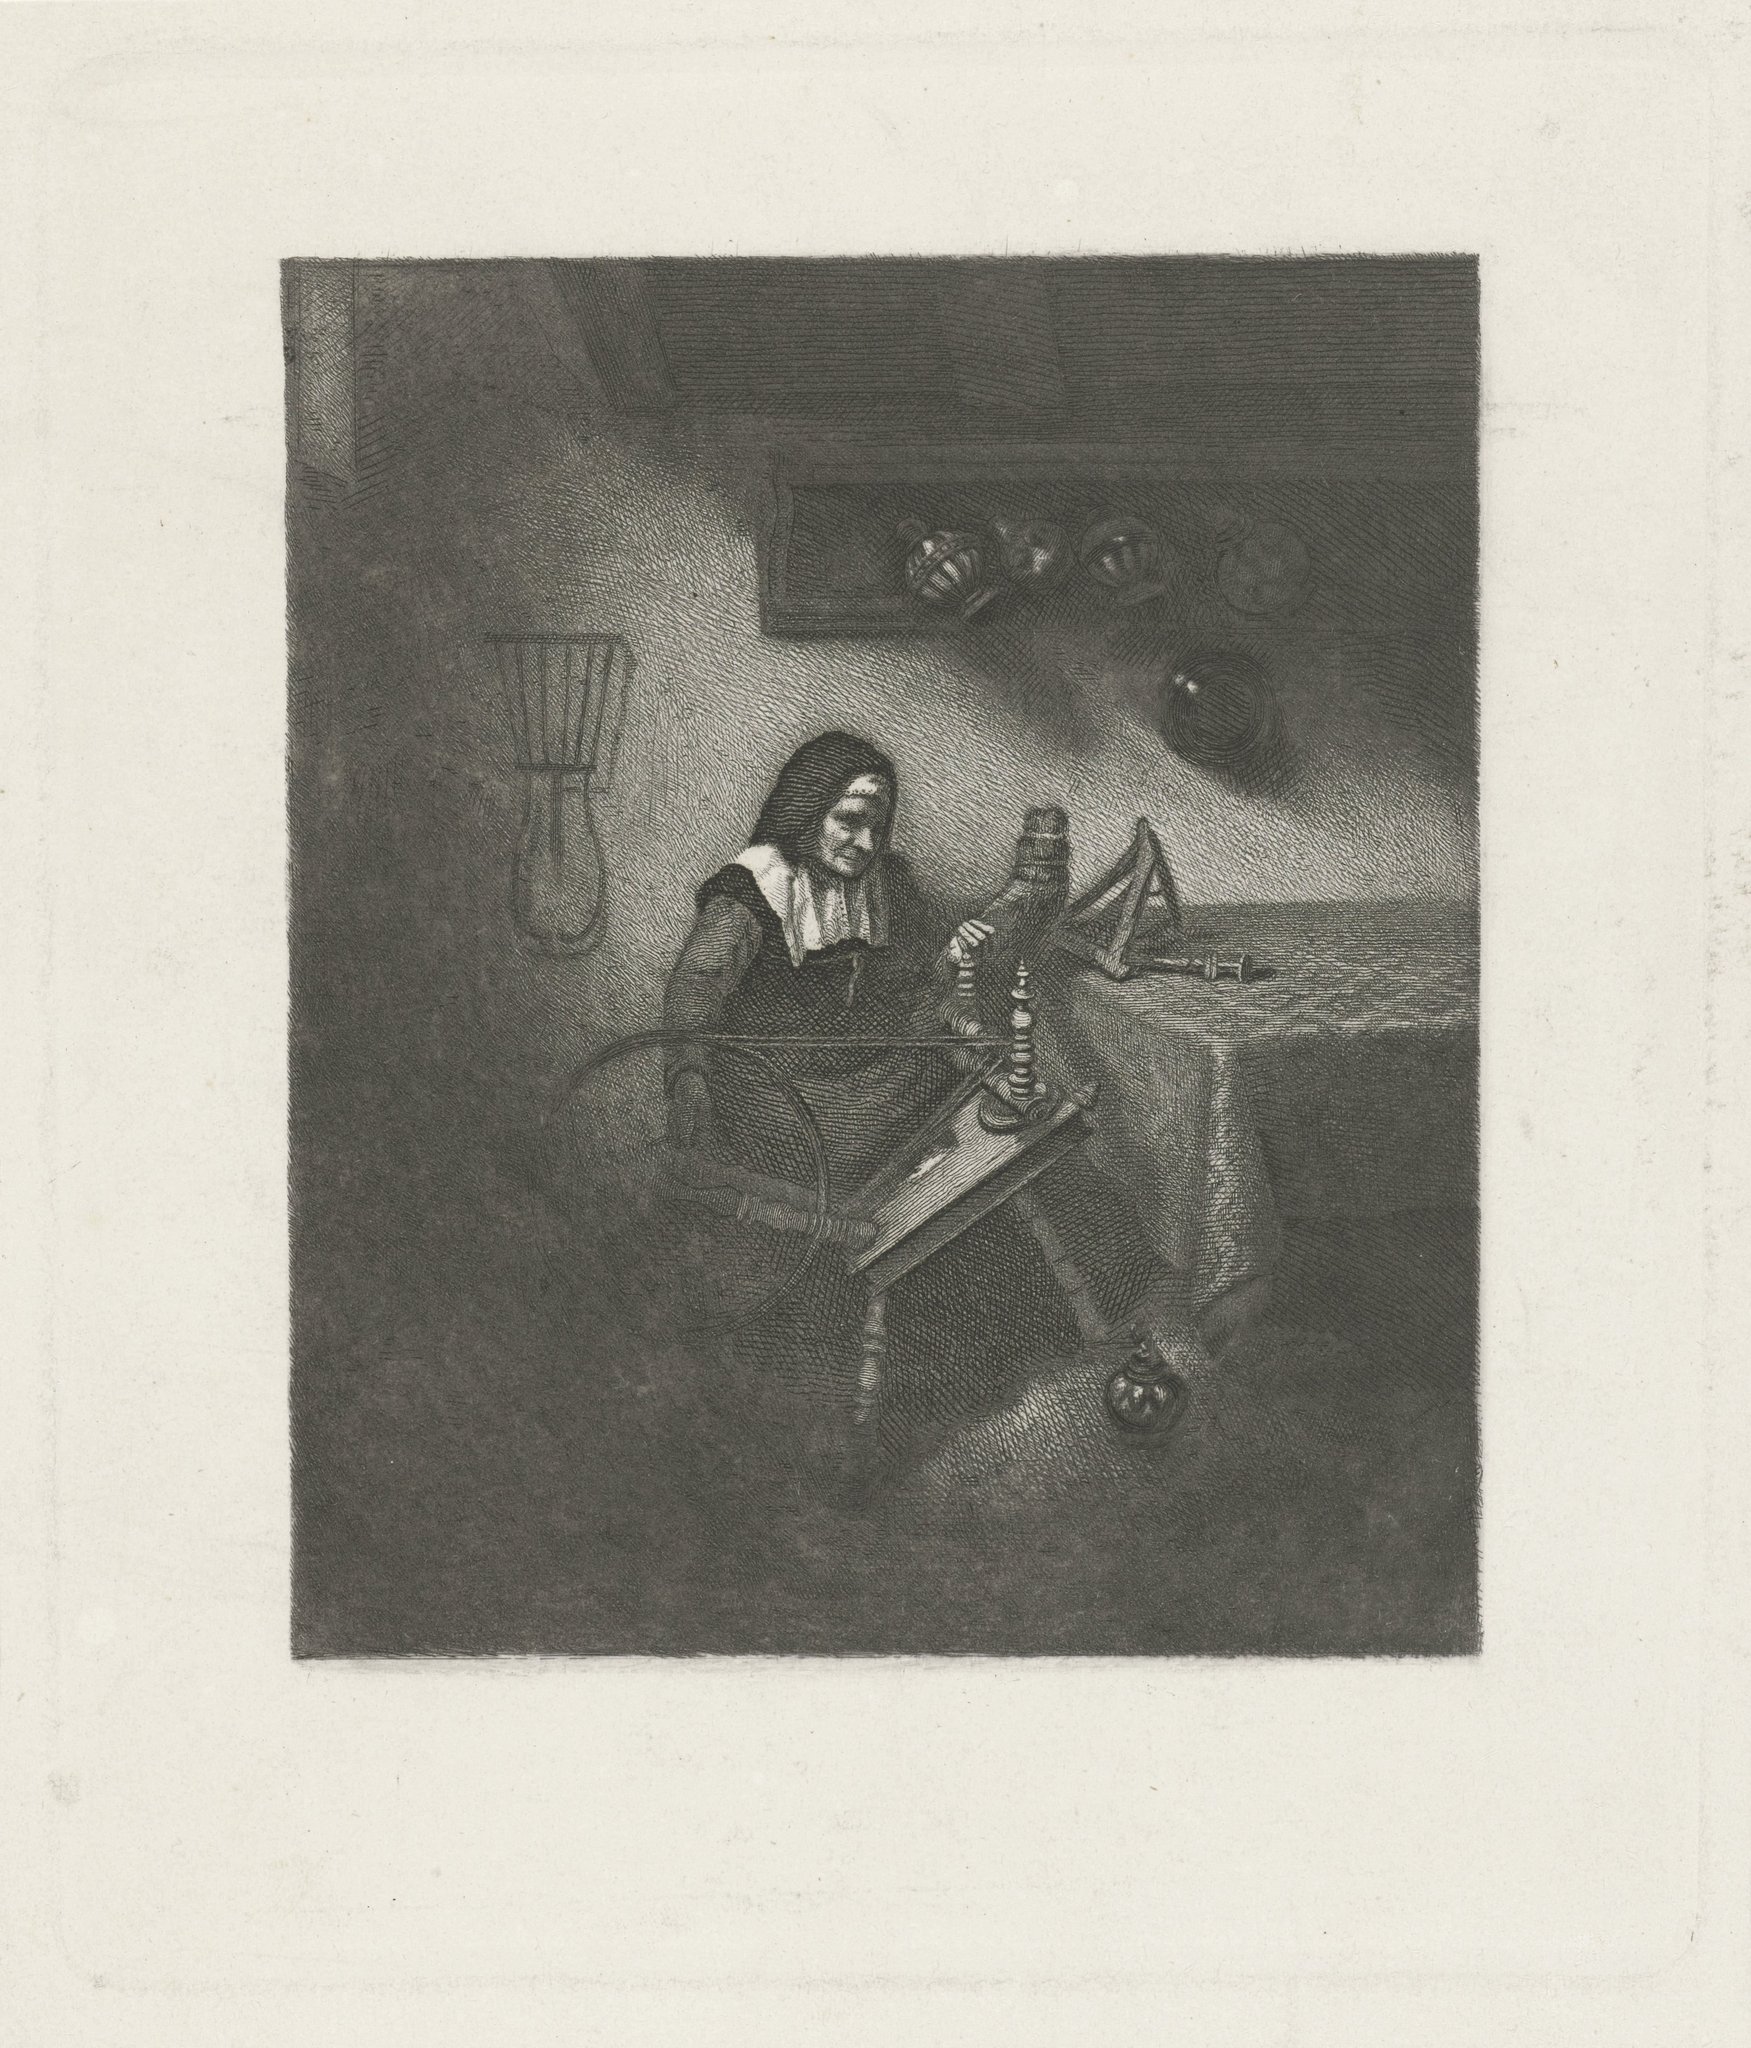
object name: print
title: Spinster aan het werk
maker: leopold löwenstam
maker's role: print maker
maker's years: 1842-1898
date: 1852-1898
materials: paper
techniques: etching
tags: spinning-wheel, interior of the house, spinning (manufacture of yarn)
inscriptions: collector's mark: Lugt 2166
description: Een oude vrouw, wol spinnend in een interieur.